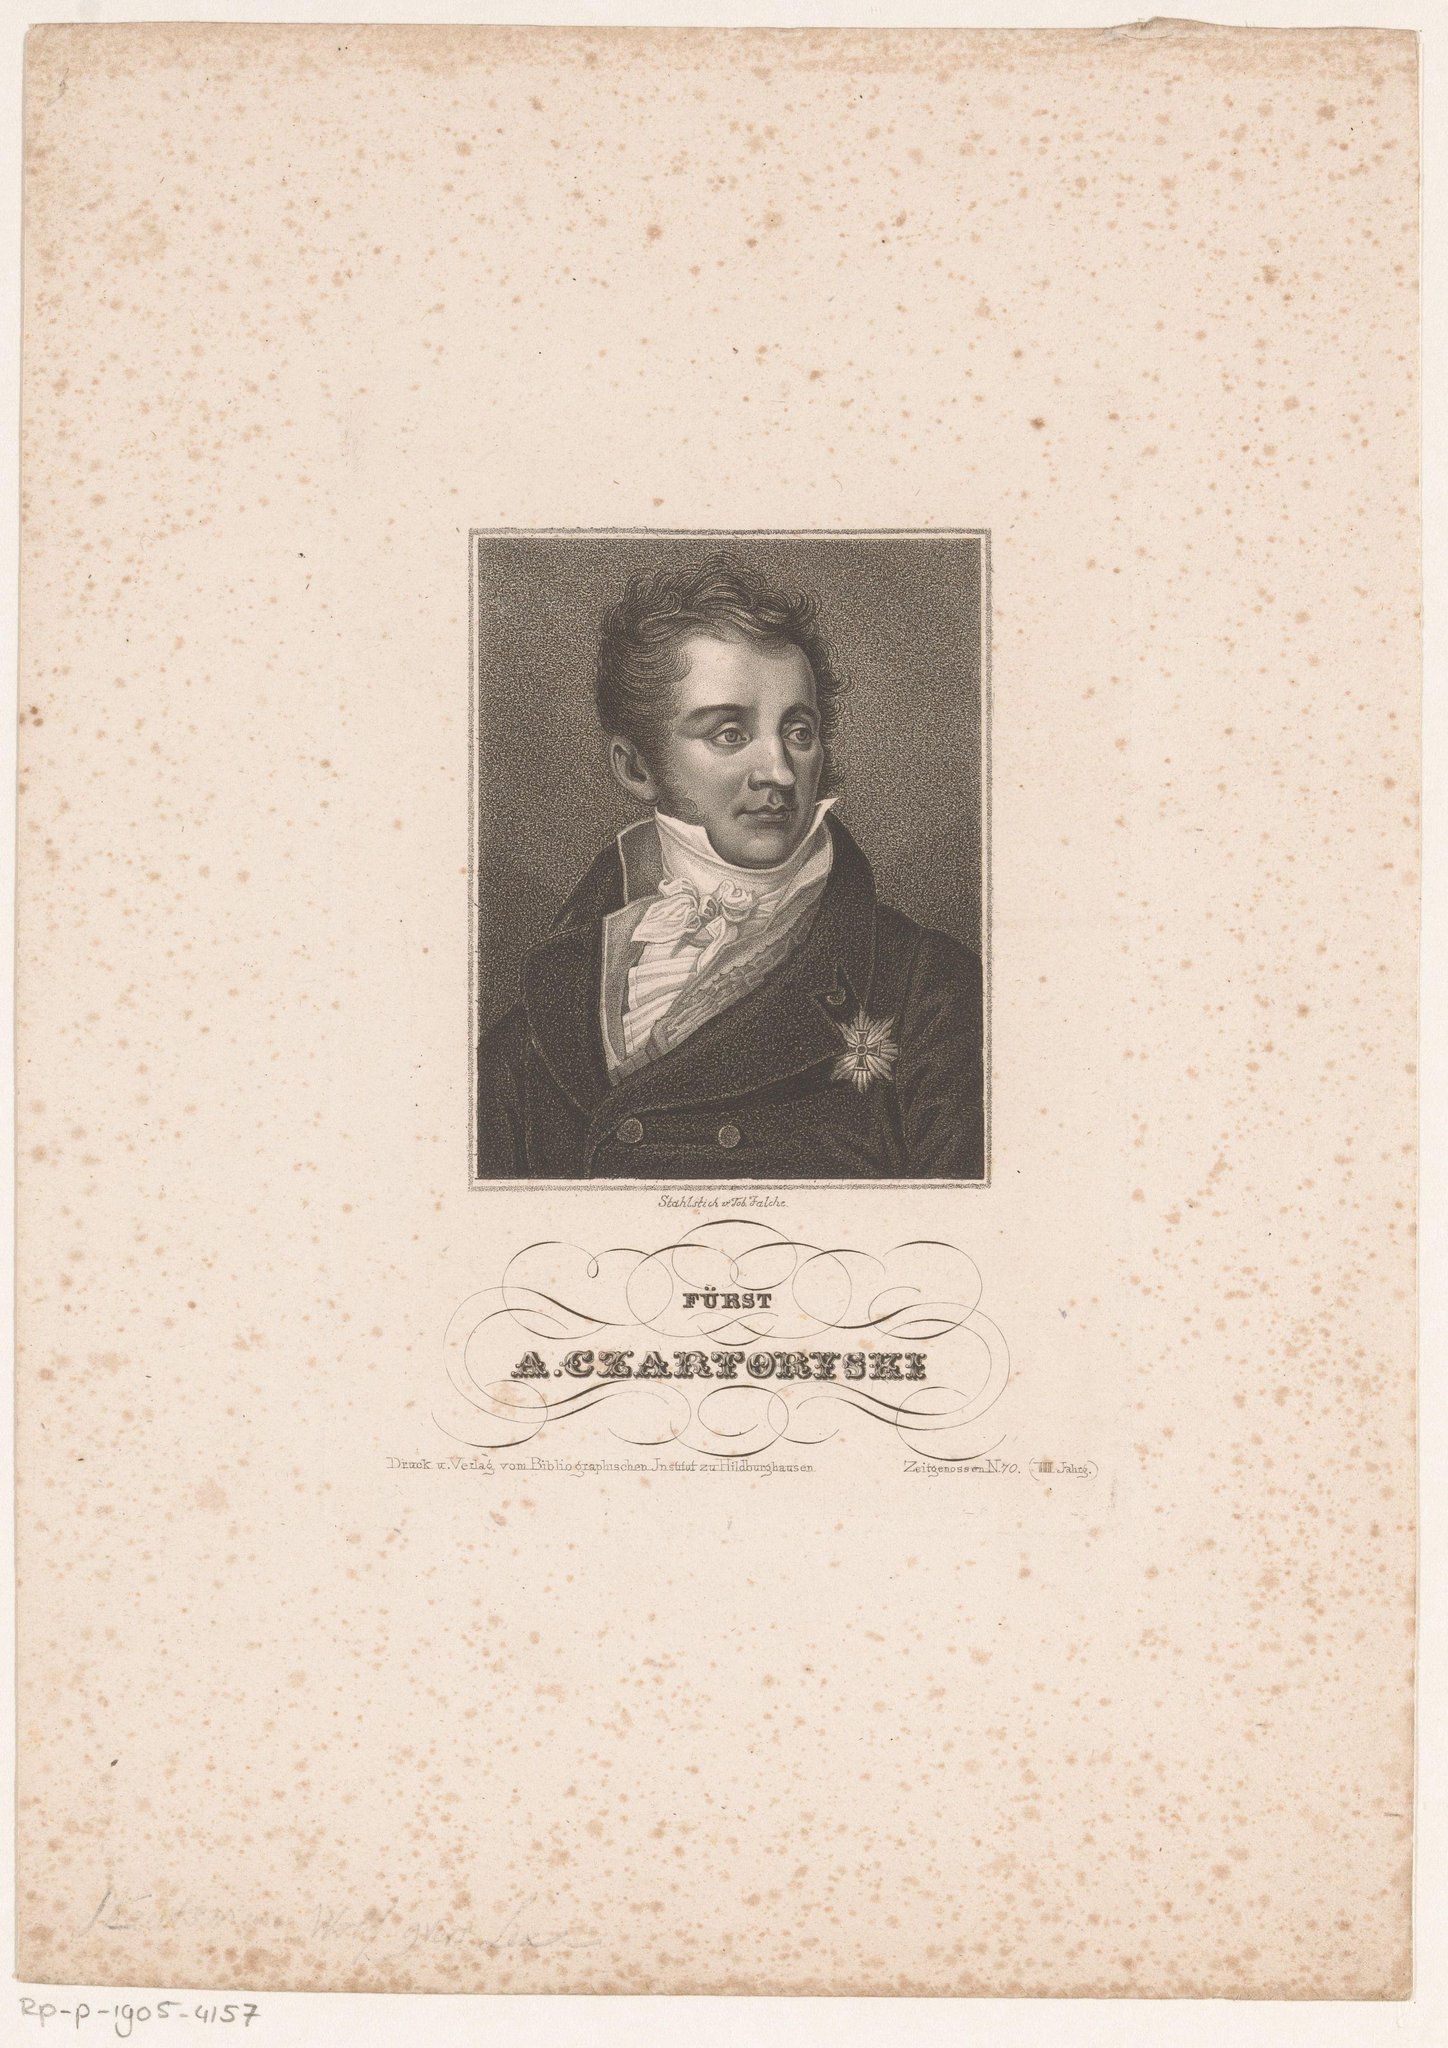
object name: print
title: Zeitgenossen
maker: tobias falke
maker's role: print maker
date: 1829-1840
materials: paper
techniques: engraving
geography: hildburghausen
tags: politician, adam jerzy czartoryski, historical persons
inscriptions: collector's mark: Lugt 2228